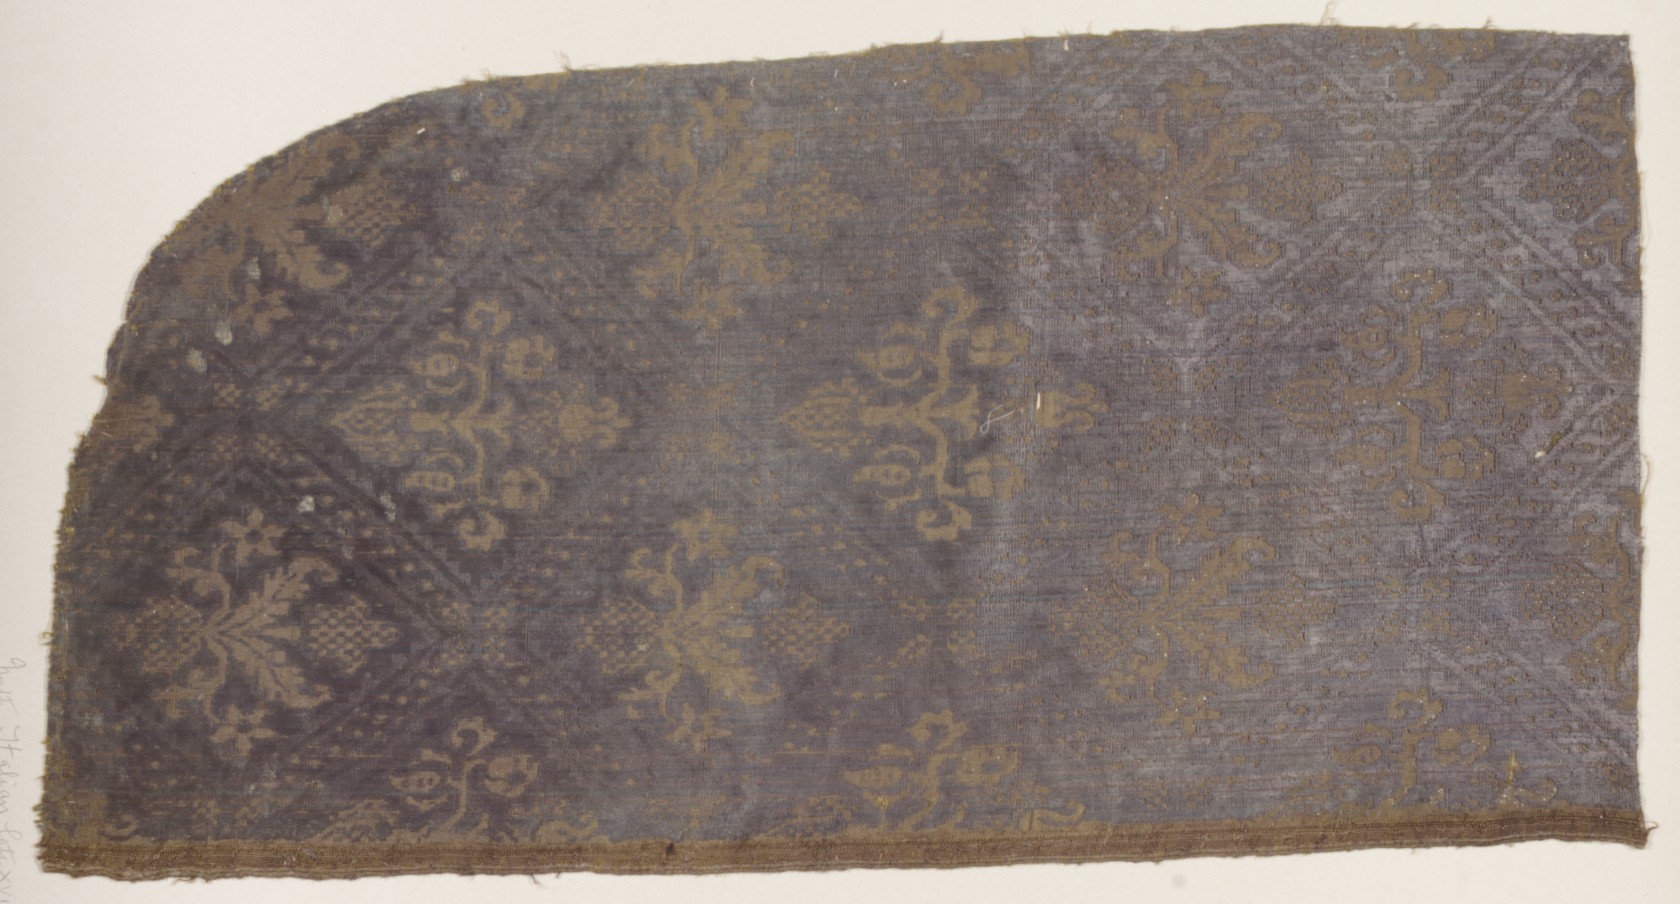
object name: fragment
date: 1567-1600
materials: silk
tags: flowers,leaves